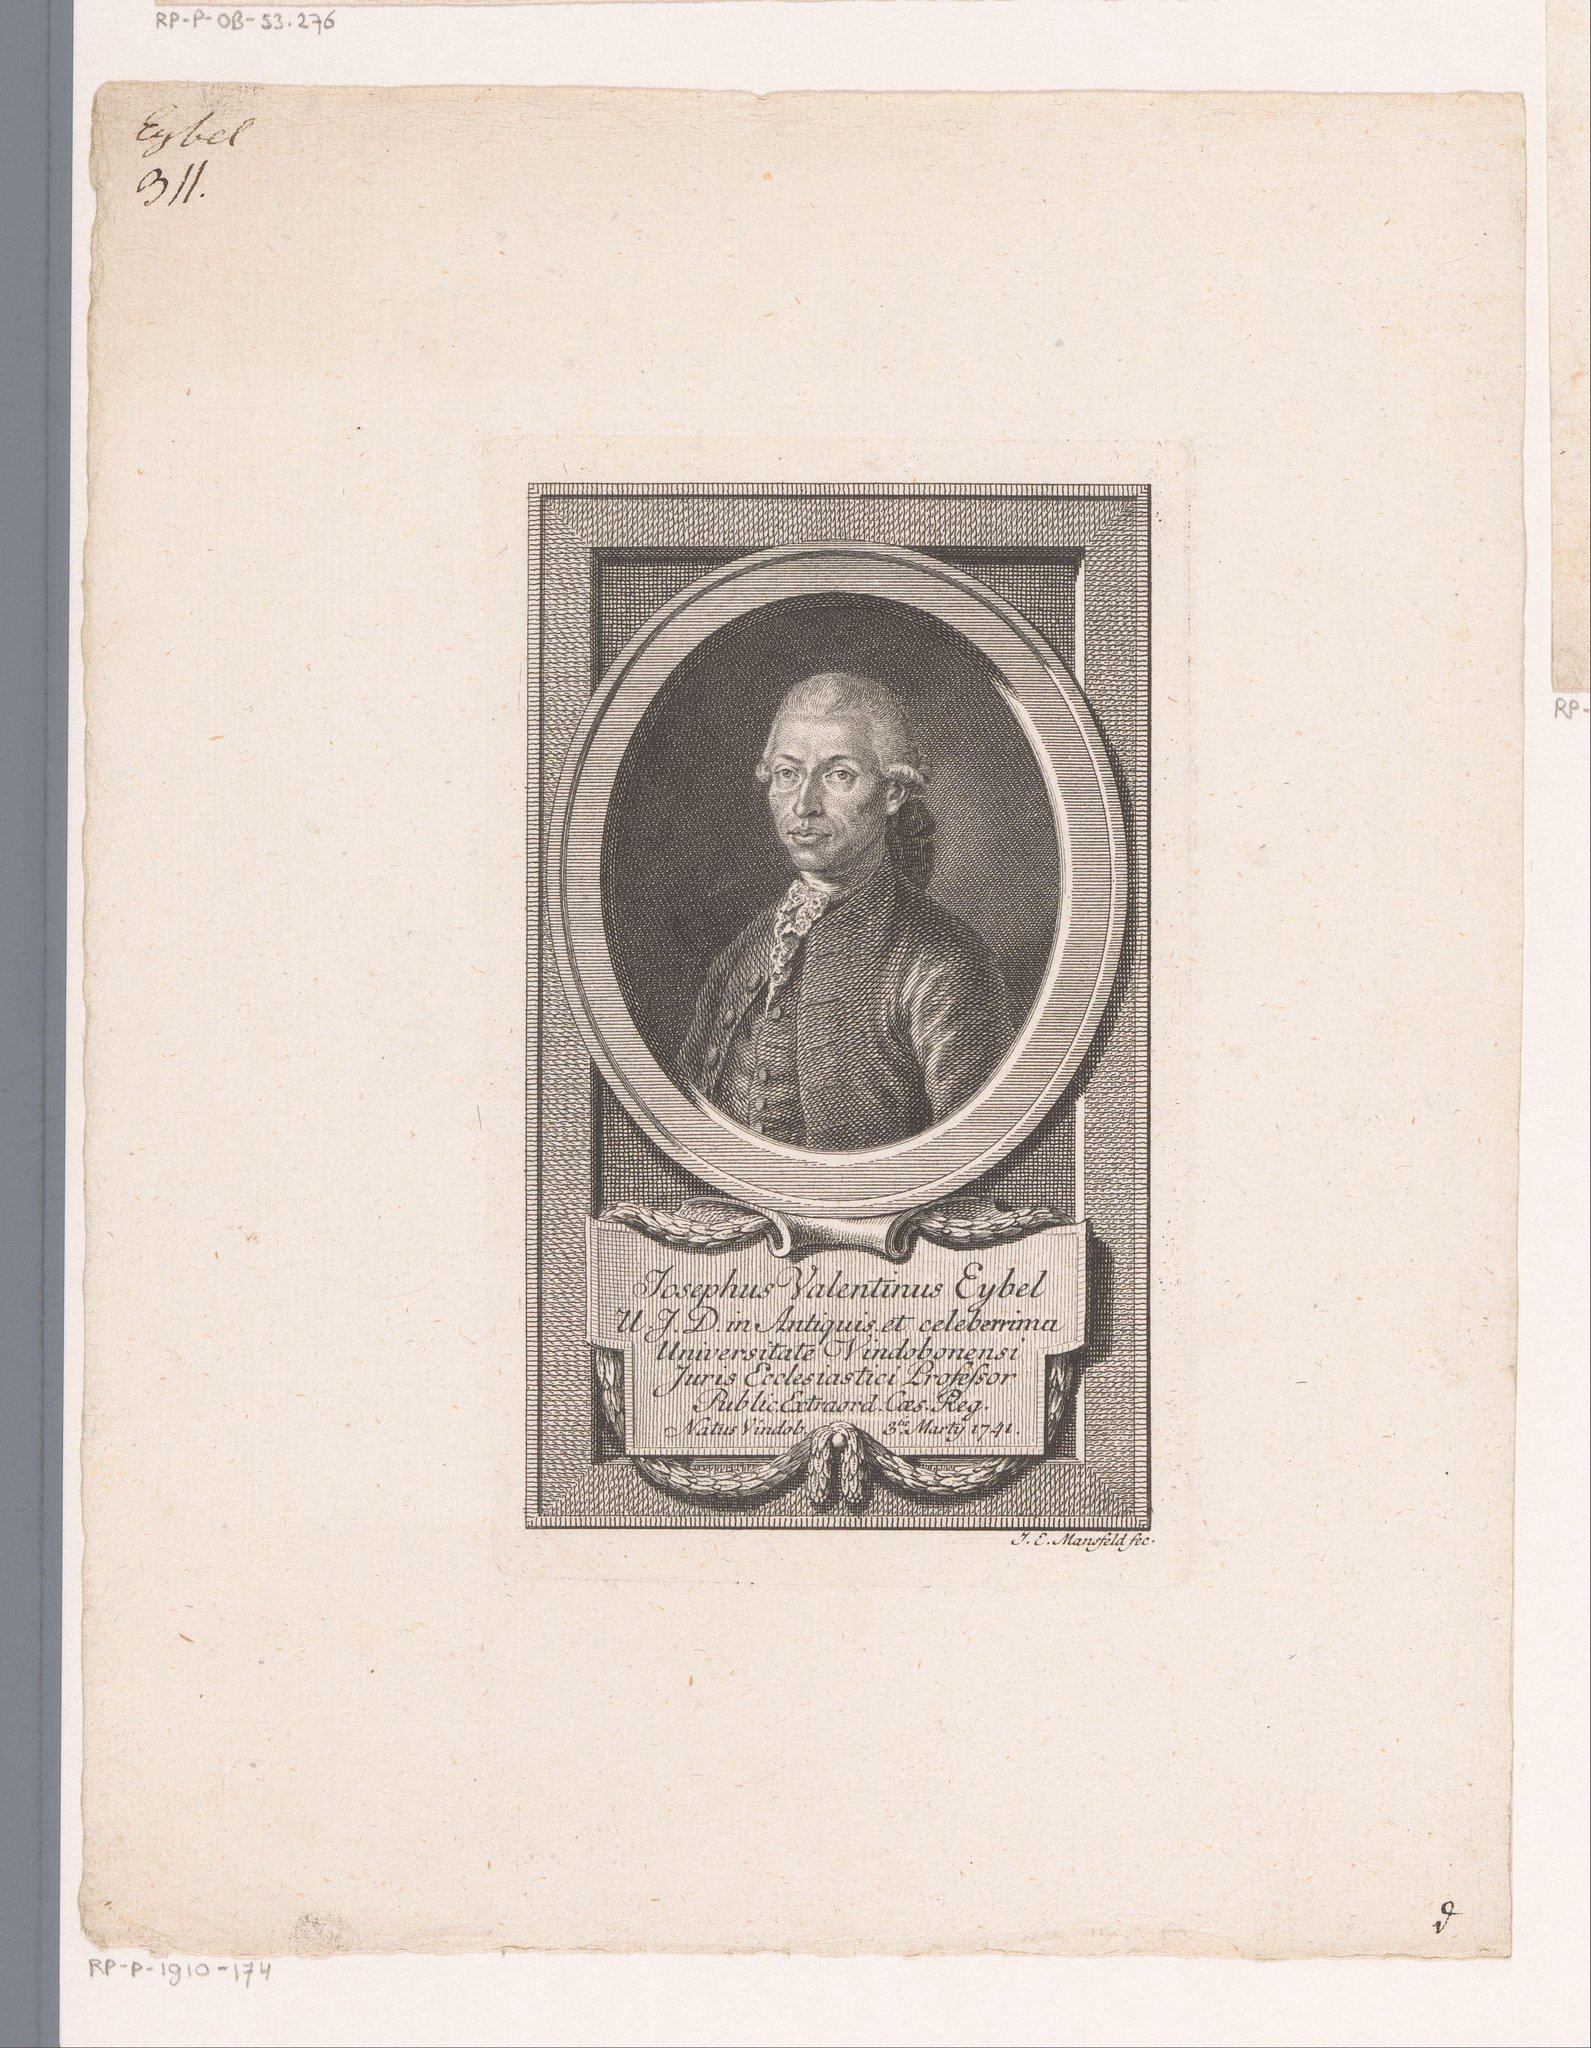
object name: print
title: Portret van Josef Valentin Sebastian Eybel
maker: johann ernst mansfeld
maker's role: print maker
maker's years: 1739-1796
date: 1749-1796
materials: paper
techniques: engraving, etching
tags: historical persons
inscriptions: collector's mark: Lugt 2228